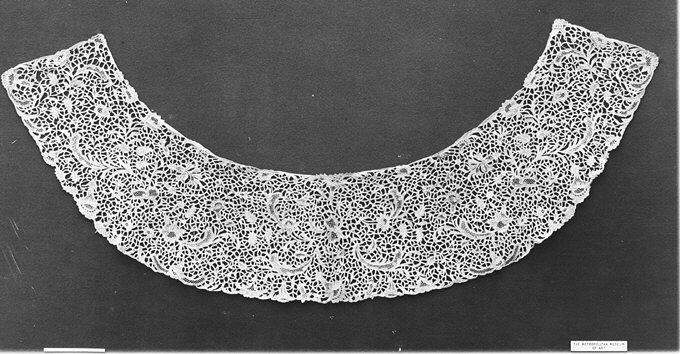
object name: collar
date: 1801-1900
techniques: lace